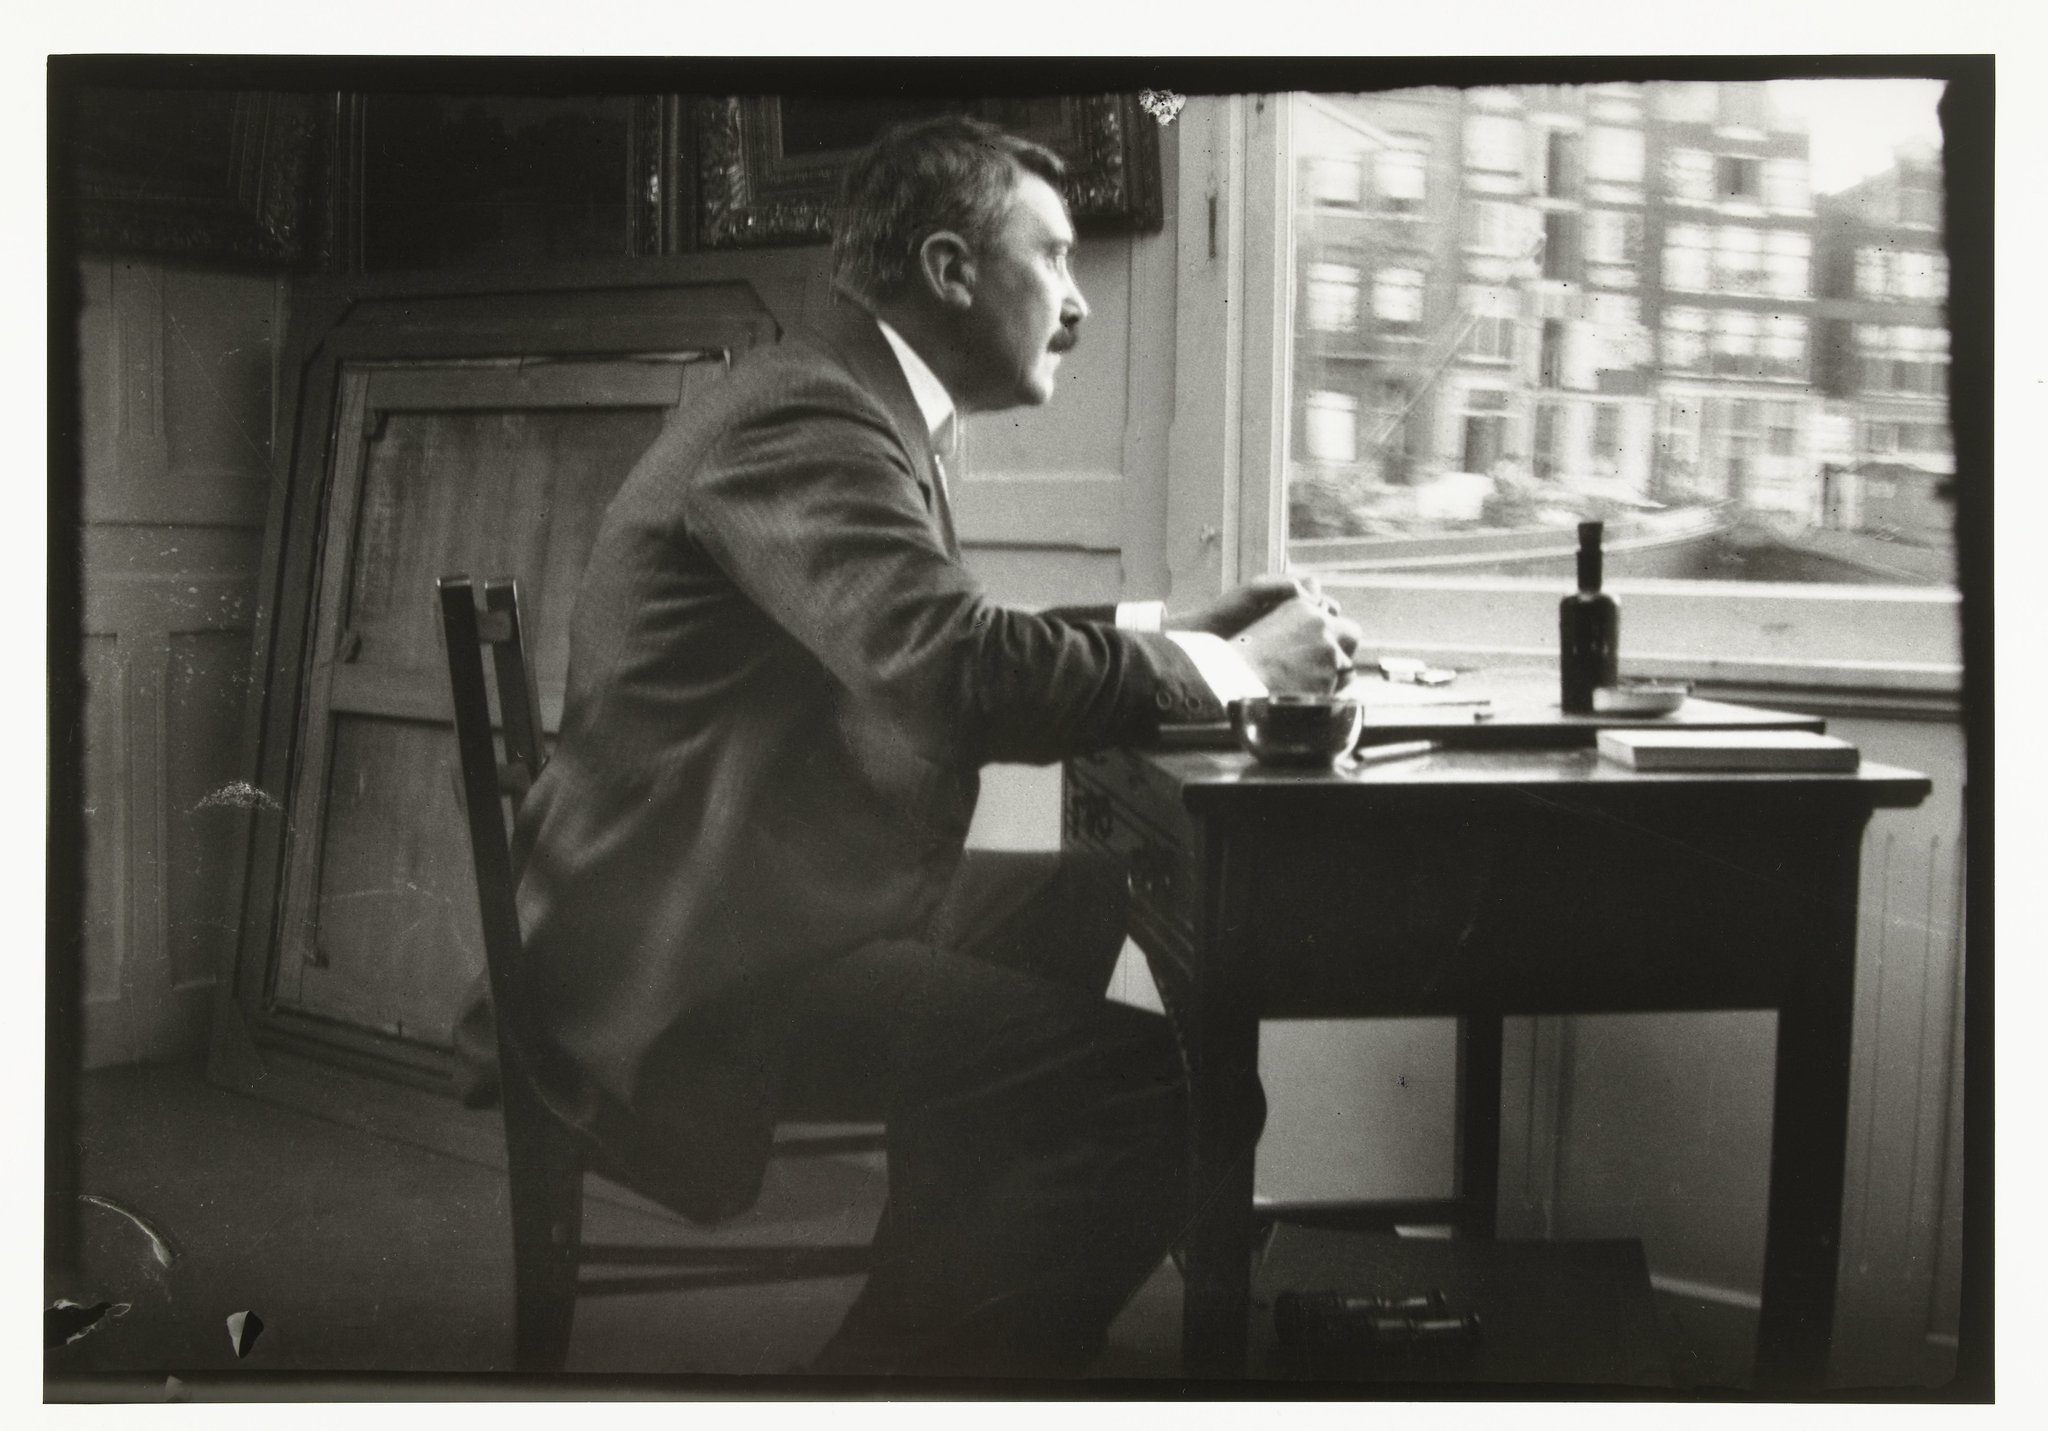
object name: photograph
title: Portret van Willem Witsen voor het raam van zijn boot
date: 1911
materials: paper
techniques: gelatin silver print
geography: amsterdam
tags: painter, print maker, draughtsman, willem witsen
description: Door het raam zijn de panden Kromme Waal 18-21 te zien